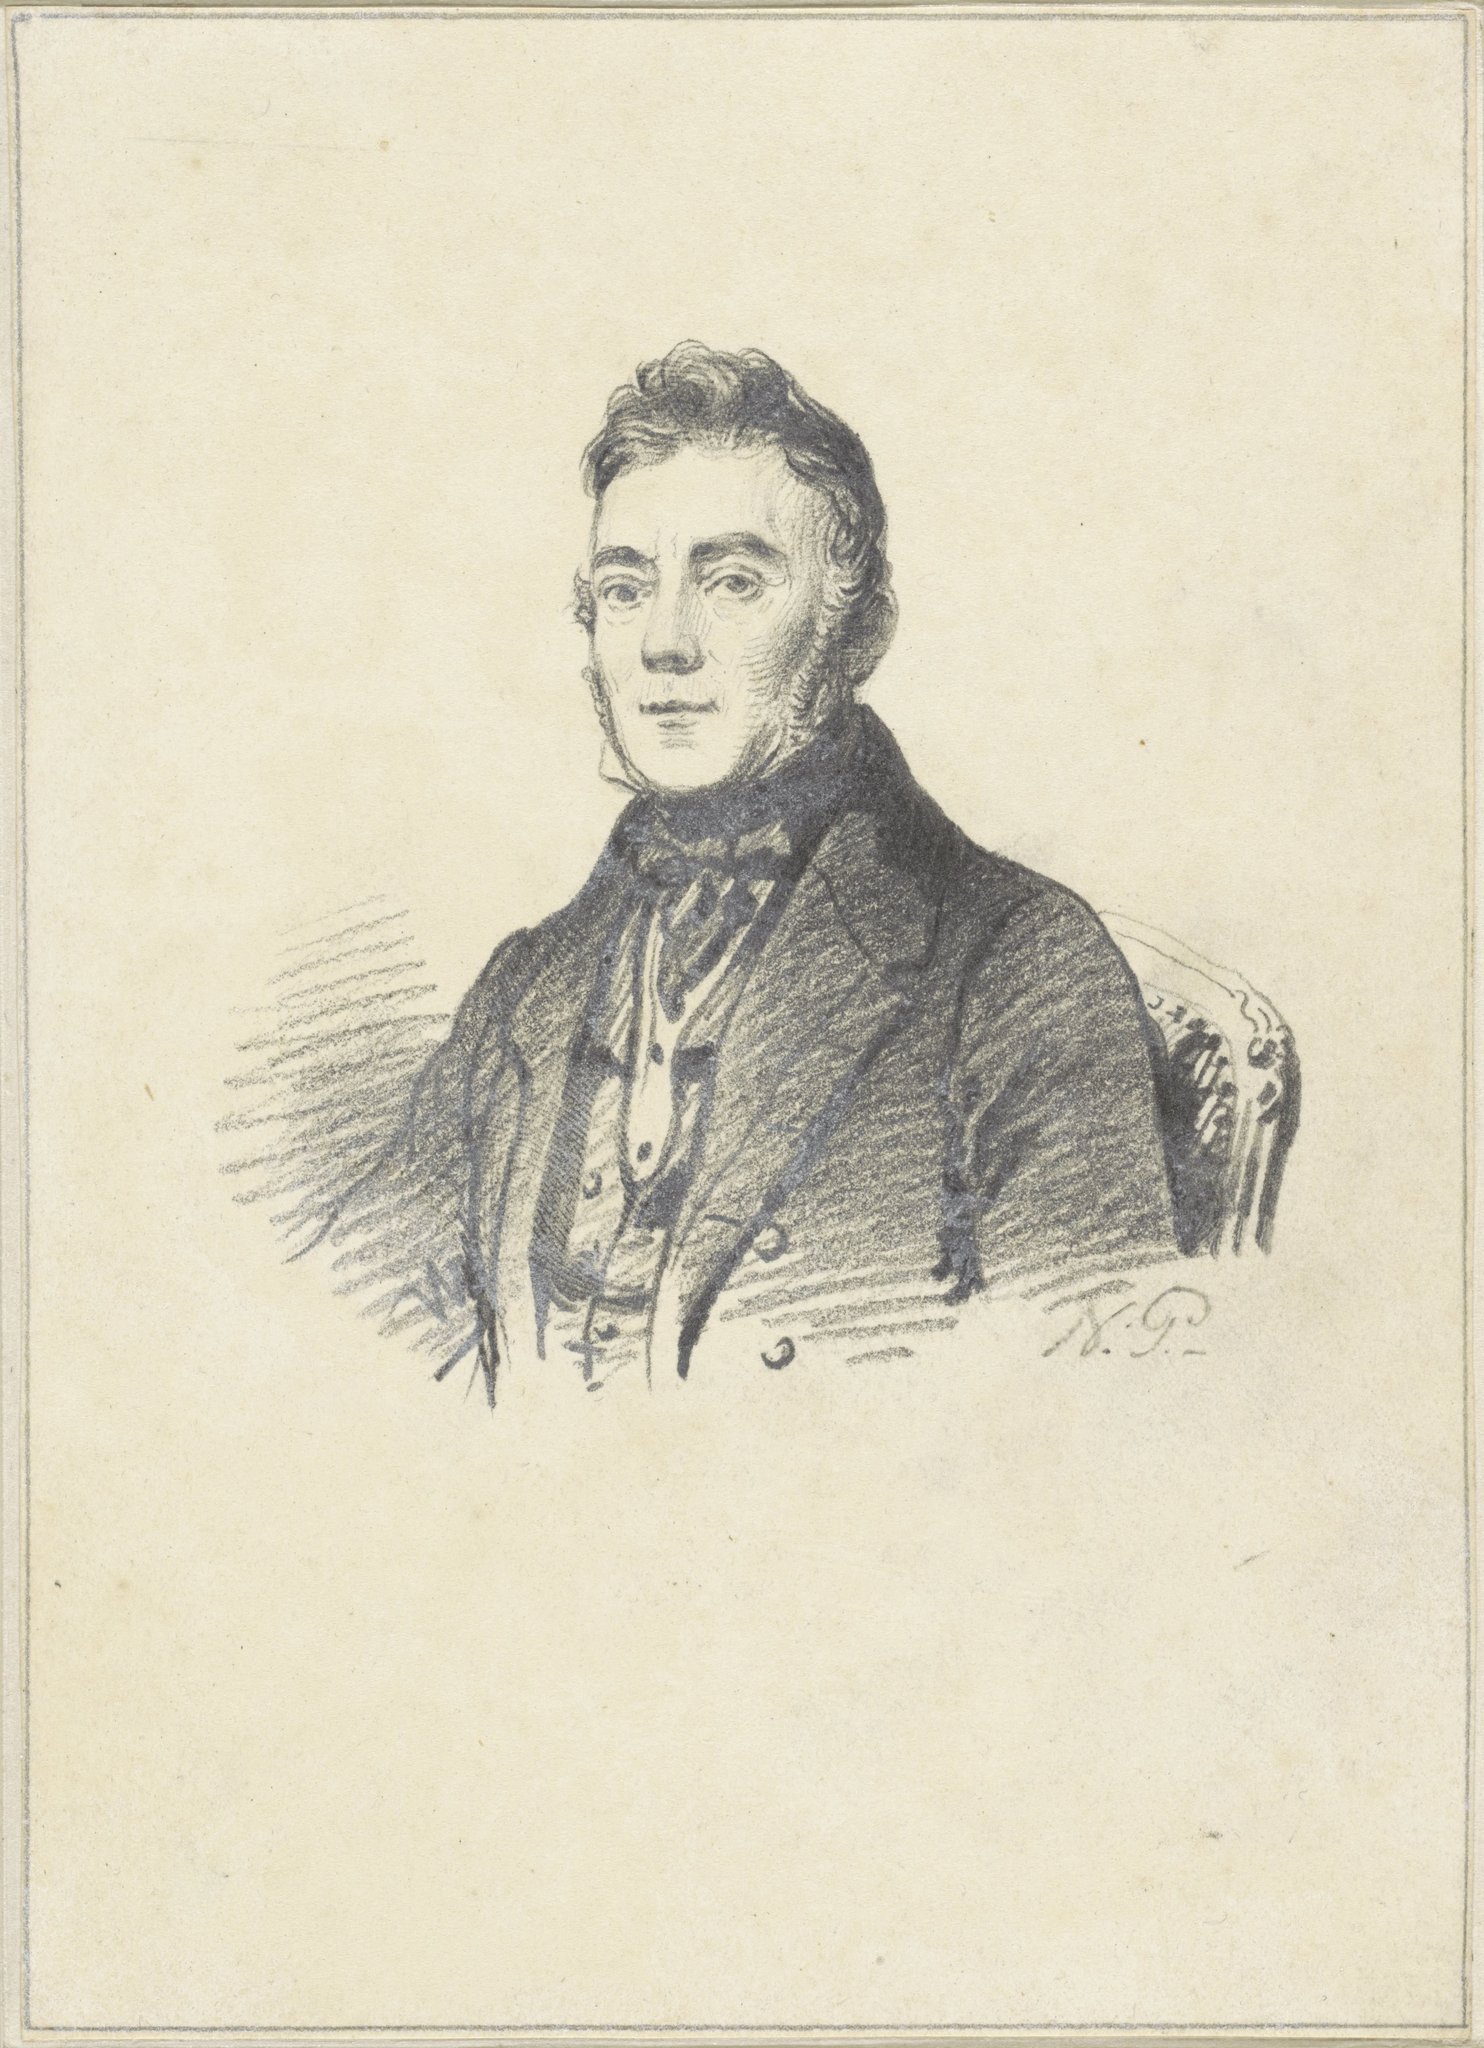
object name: drawing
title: Portret van de schilder George Pieter Westenberg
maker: nicolaas pieneman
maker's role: draughtsman, painter, print maker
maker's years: 1809-1860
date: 1819-1860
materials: paper, pencil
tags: nijmegen, george pieter westenberg, historical persons, portrait, self-portrait of painter, portrait, self-portrait of artist